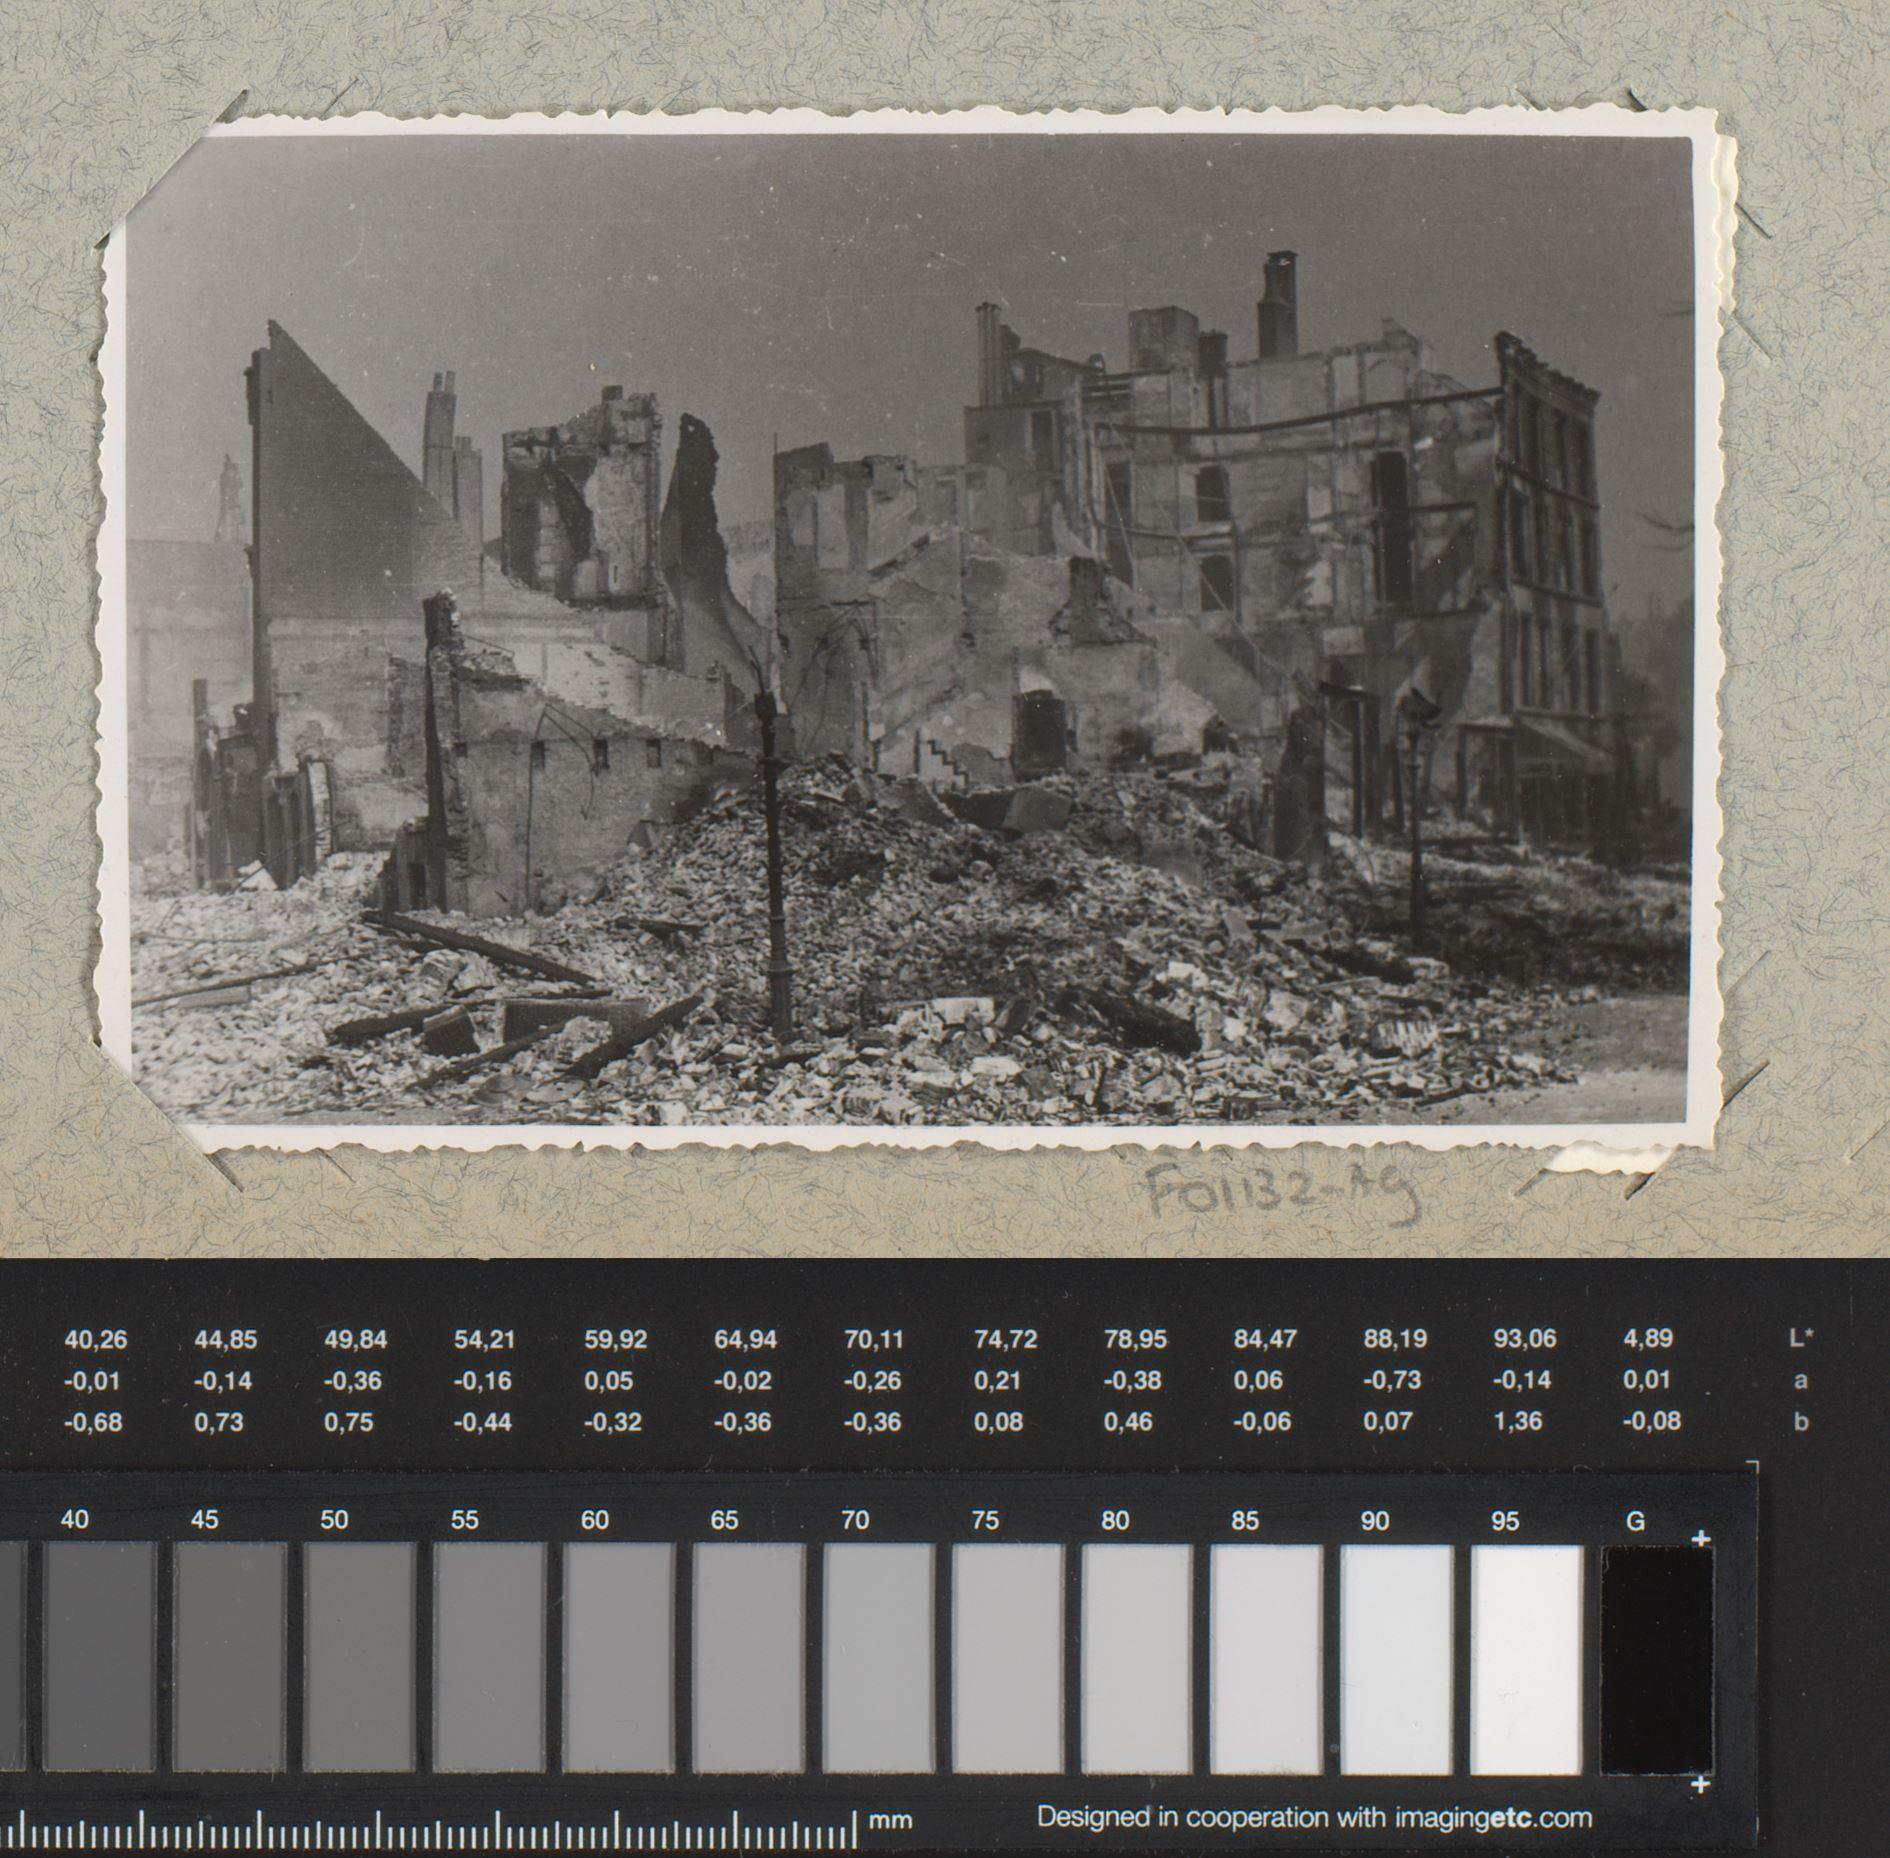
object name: photograph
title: Ruïnes bij de Witte de Withstraat richting de Schiedamsesingel te Rotterdam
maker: j. nolte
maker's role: fotograaf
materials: photographic support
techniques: gelatin silver print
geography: rotterdam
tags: devastated, ruined place or city (~ warfare), ruin of a dwelling, house, castle, etc., rotterdam, rotterdam blitz